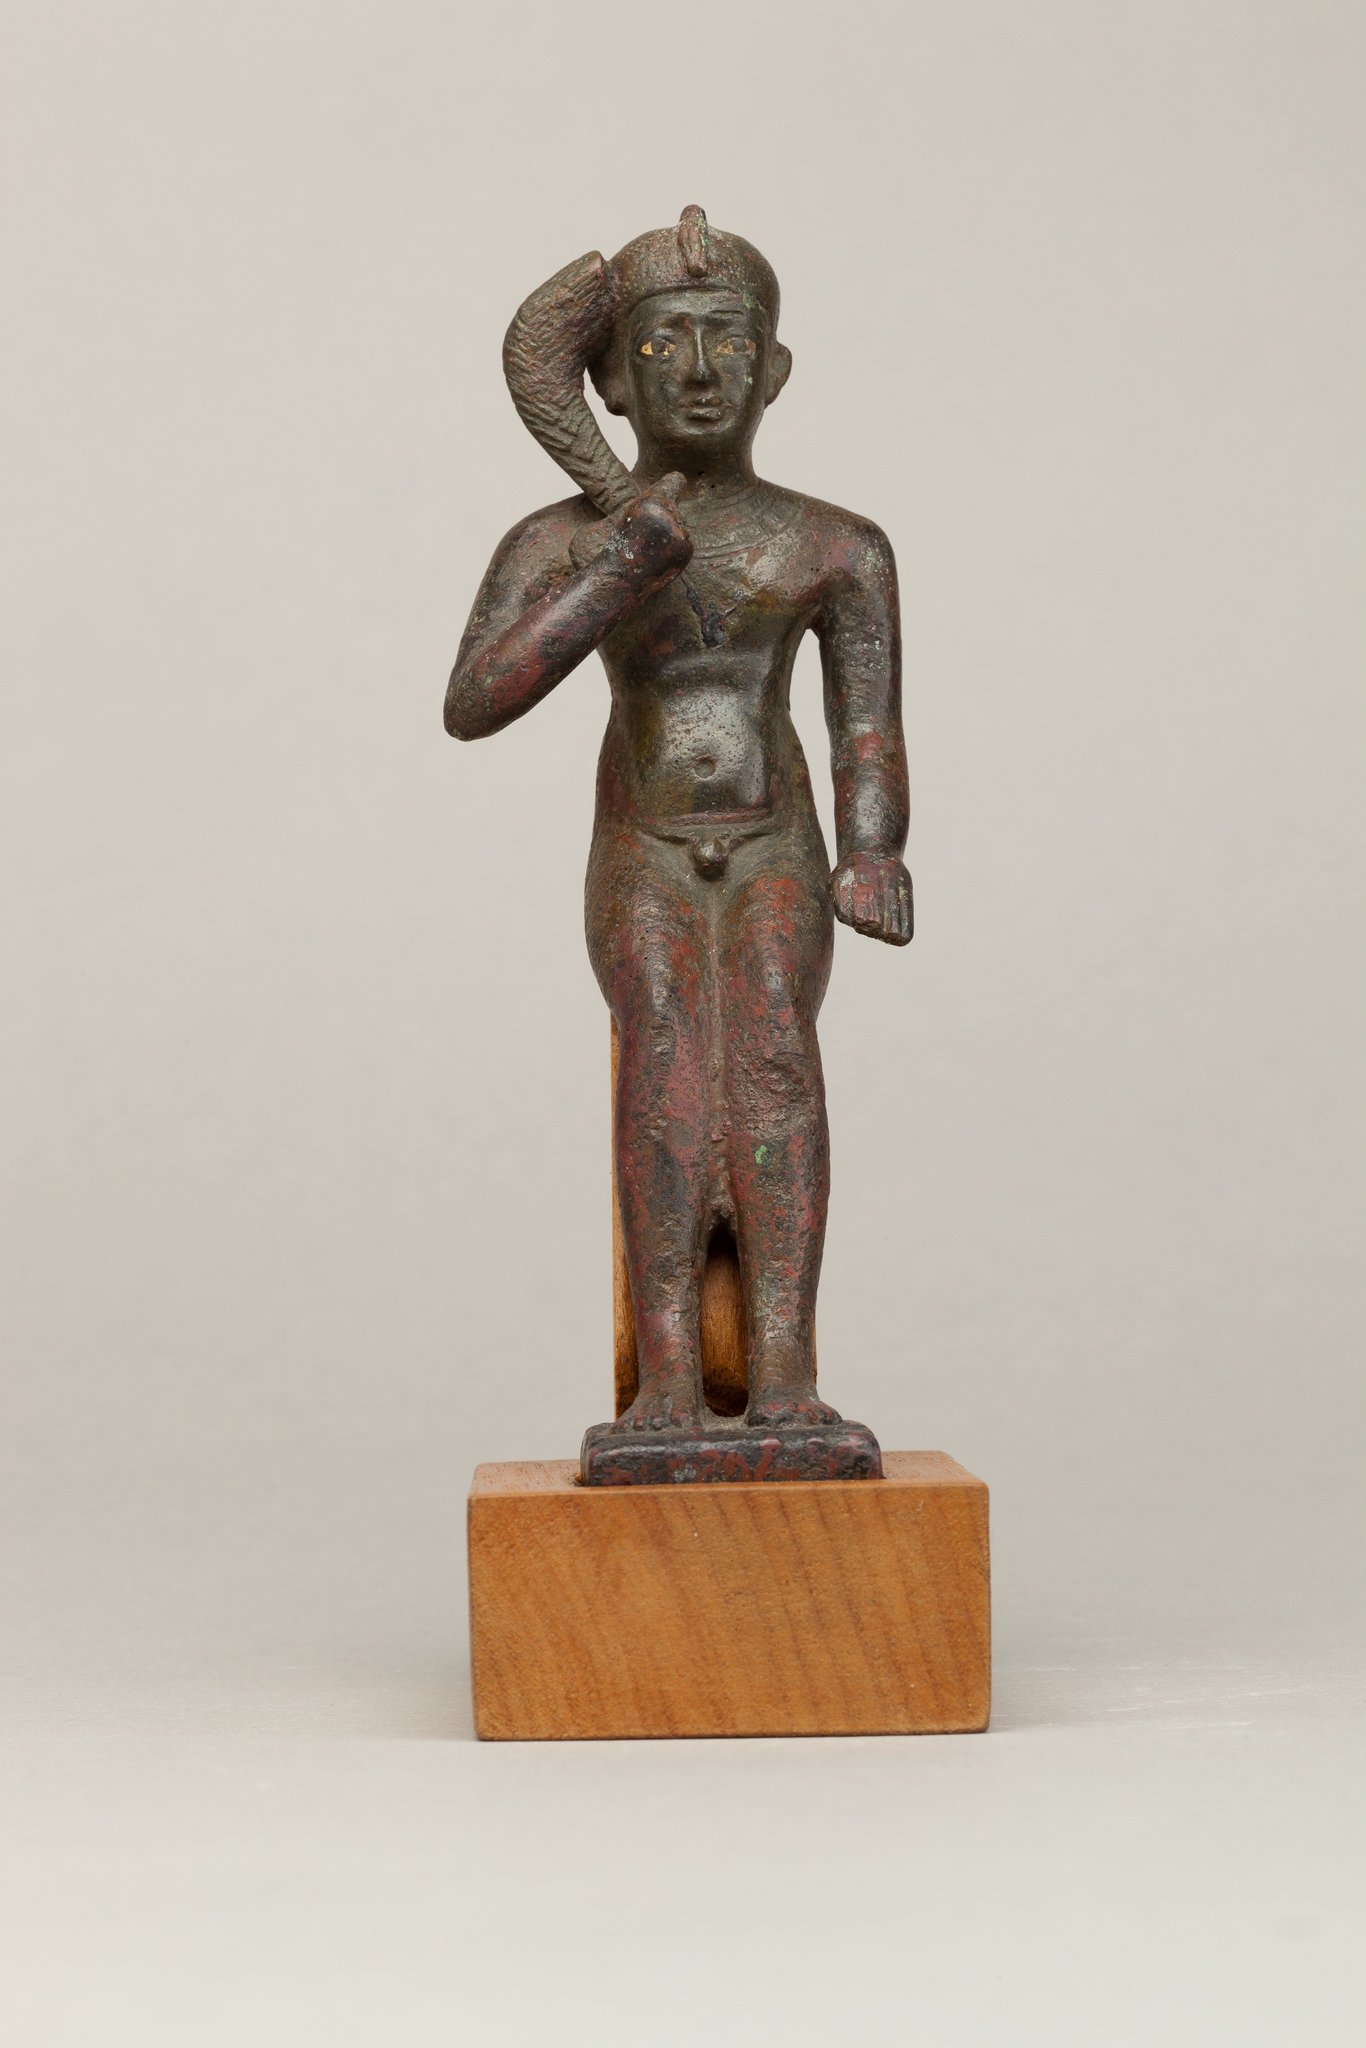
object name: statuette, child god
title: Child god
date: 664-630 BCE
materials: metal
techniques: inlay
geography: egypt